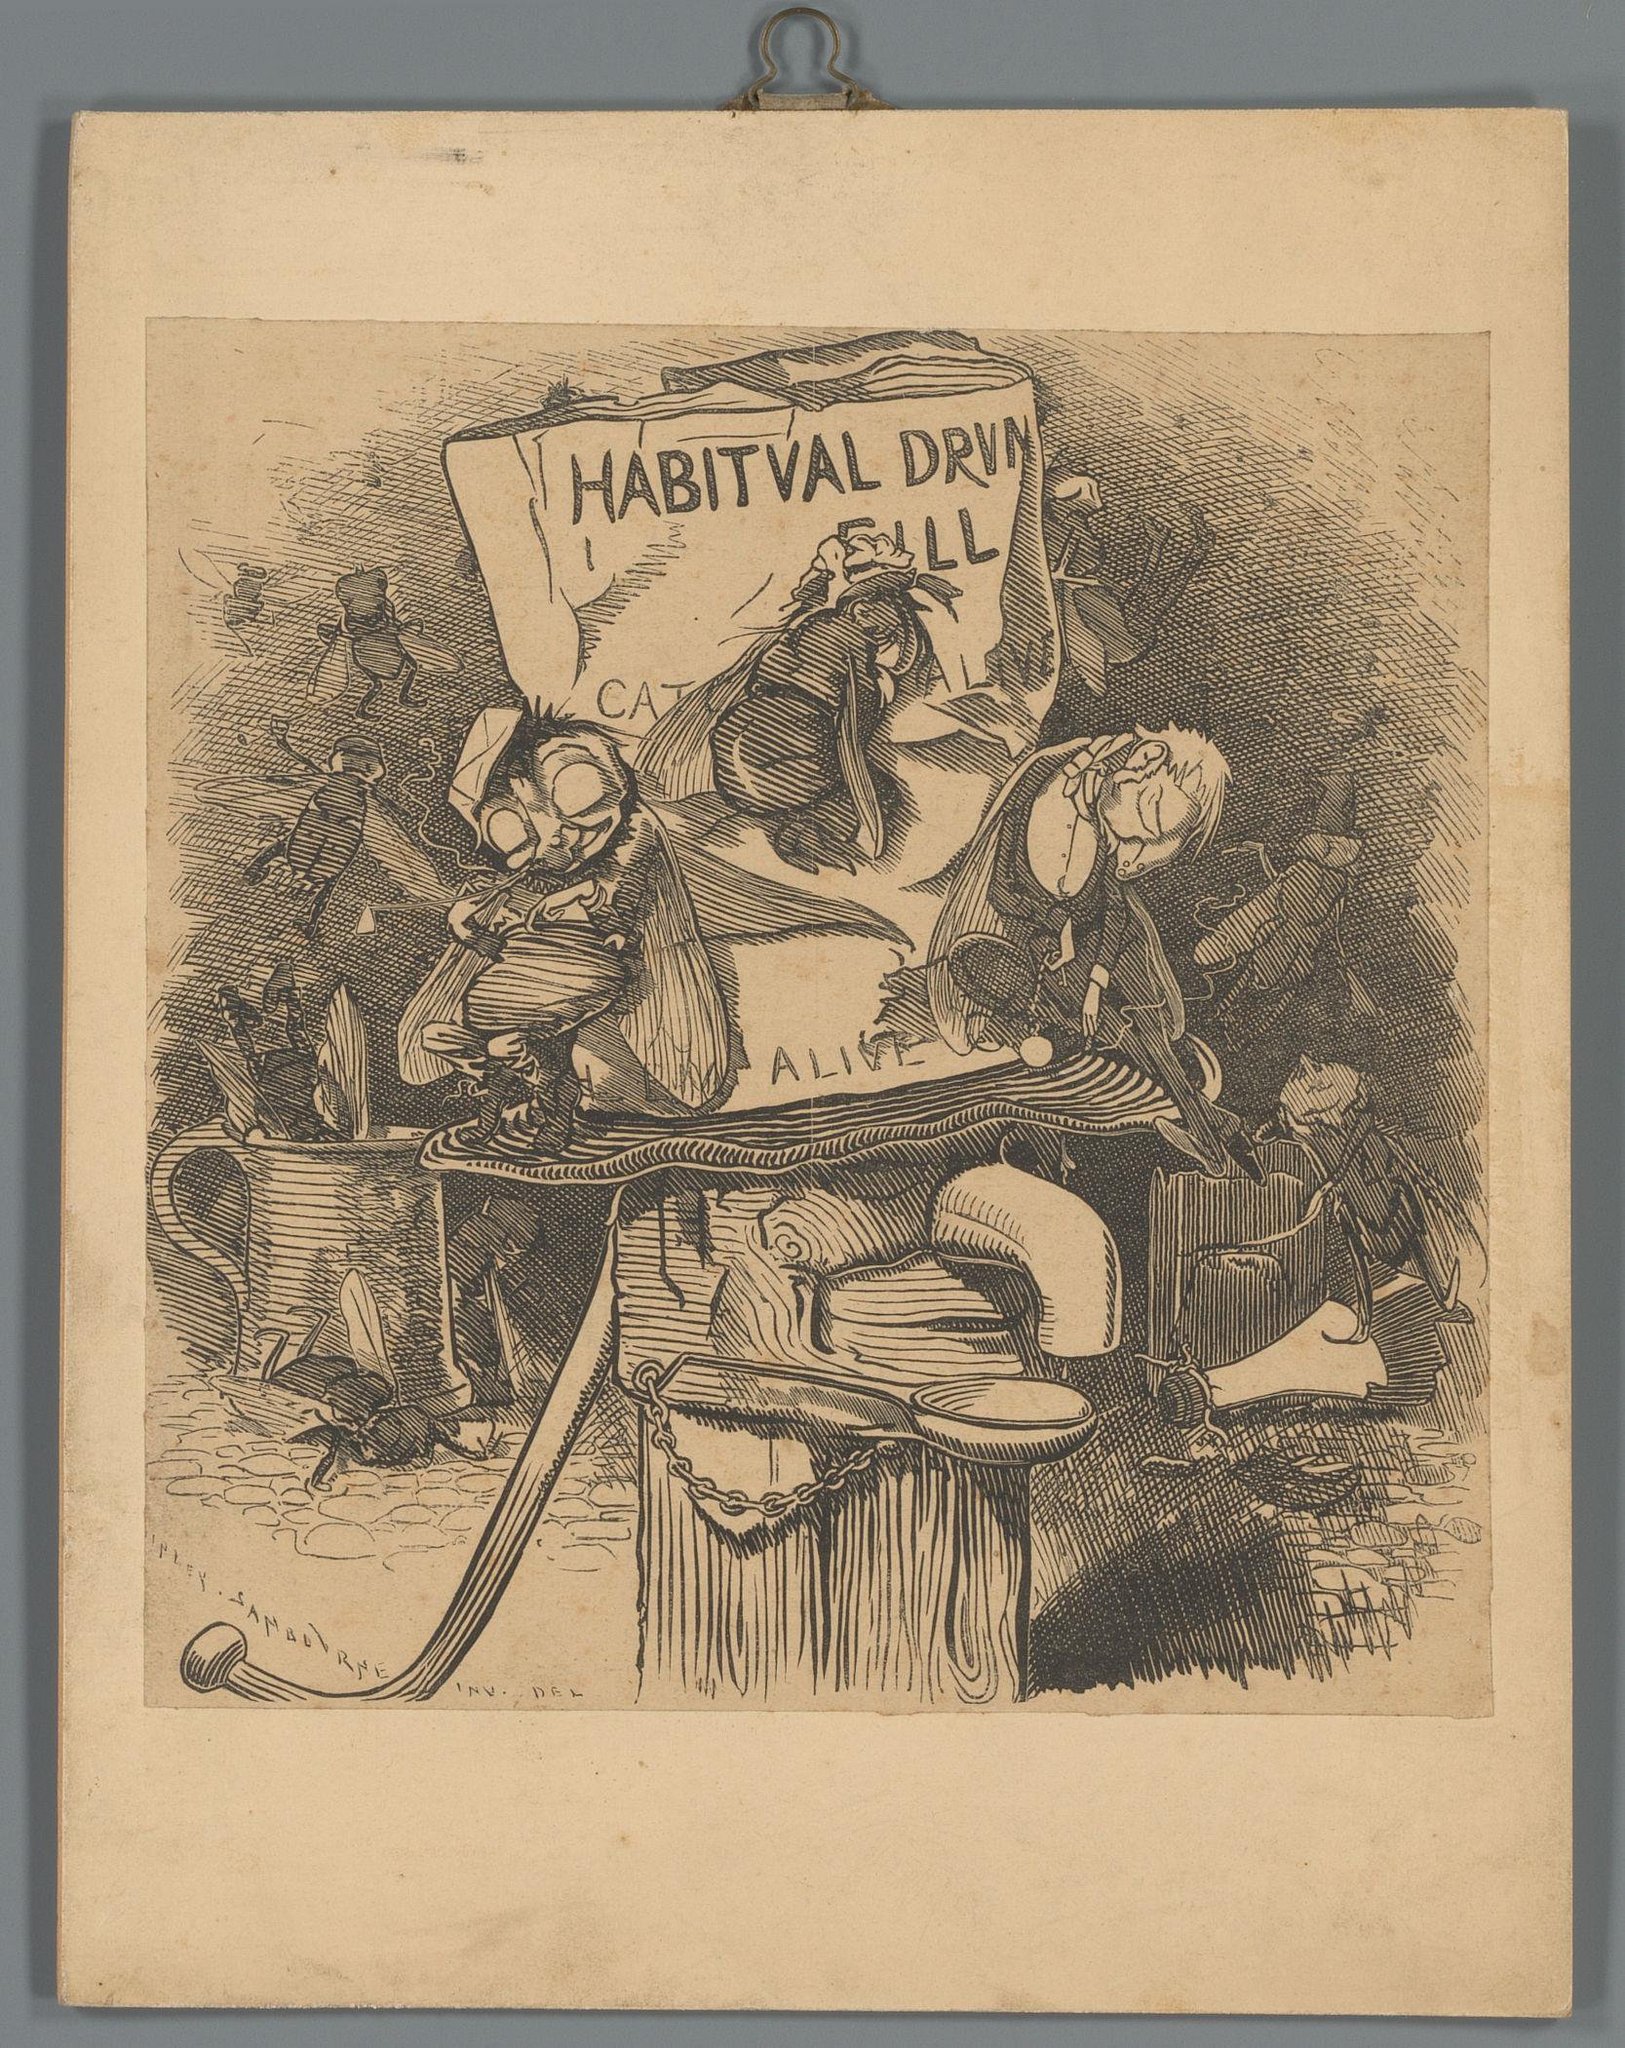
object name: print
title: Dronken vliegen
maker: edward linley sambourne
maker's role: draughtsman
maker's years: 1844-1910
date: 1890-1905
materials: paper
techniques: line block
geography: england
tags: animals acting as human beings, drunkenness, pump, political caricatures and satires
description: Spotprent met dronken vliegen rond een waterpomp voorgesteld als de kop van een man met een hoge hoed. Spotprent, mogelijk uit het Engelse satirische tijdschrift Punch, of uit een ander blad. Opgeplakt op karton en voorzien van een haakje. ca. 1890-1905.